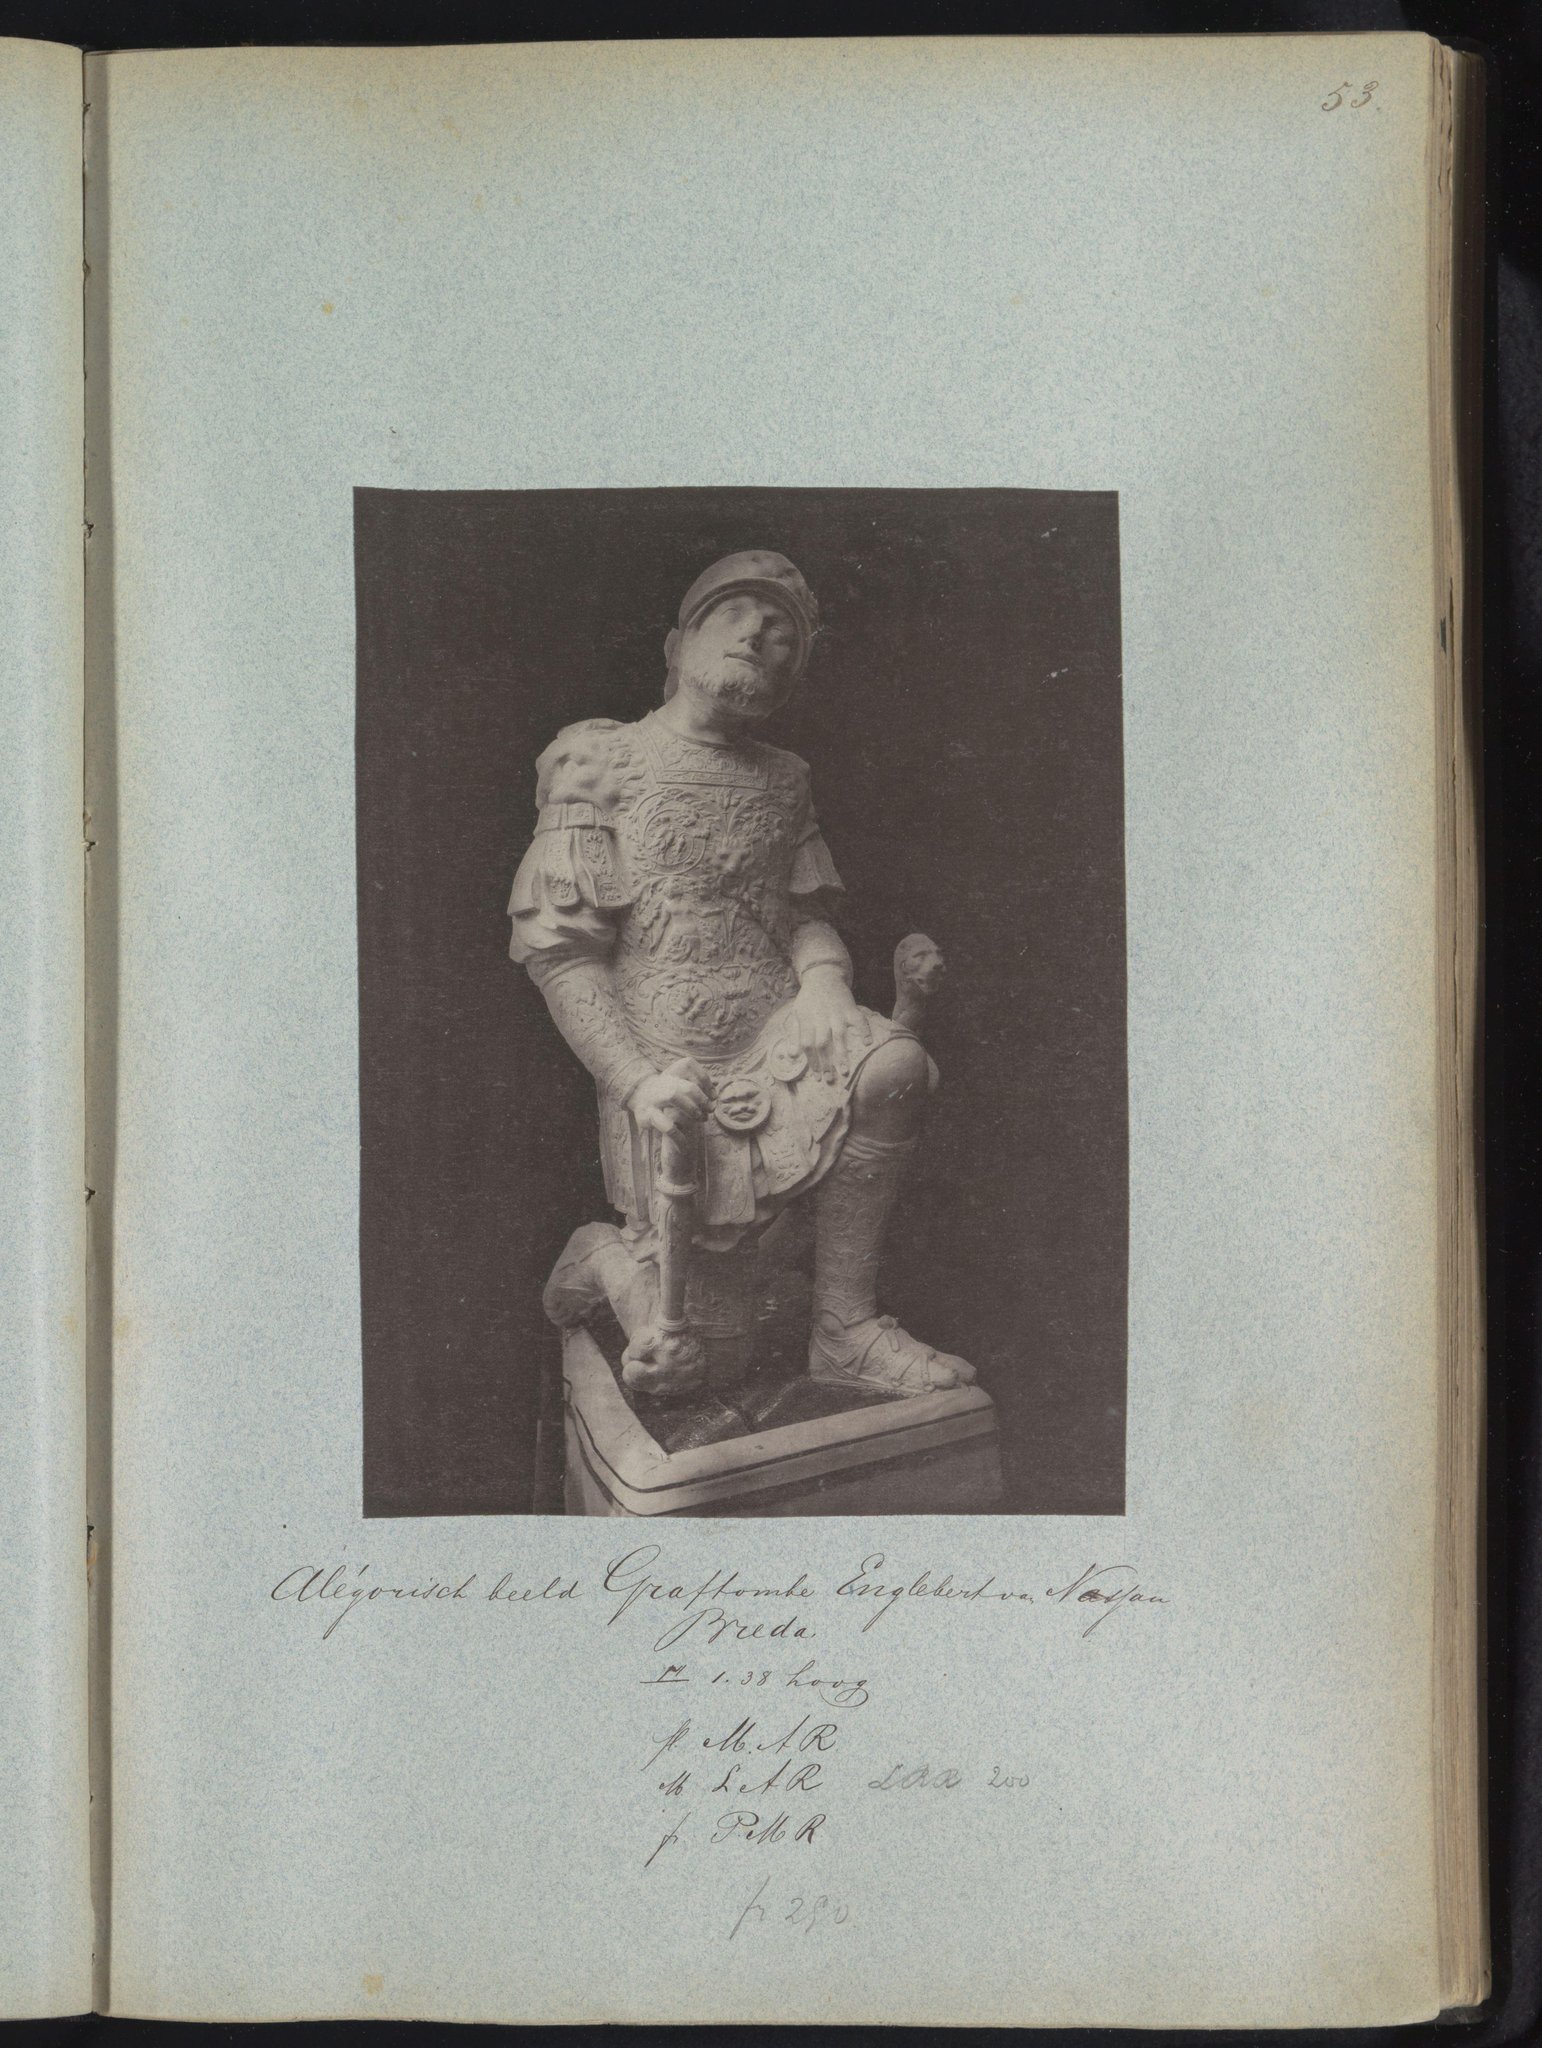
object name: album leaf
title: Gipsen afgietsel van beeld van de graftomble van Engelbrecht II, graaf van Nassau, uit de Prinsenkapel van de Onze-Lieve-Vrouwekerk te Breda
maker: Anonymous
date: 1875-1900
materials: paper, photographic support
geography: breda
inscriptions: annotation, annotation: ‘Allegorisch beeld Graftombe Englebert Nassau / Breda / 1.38 hoog’